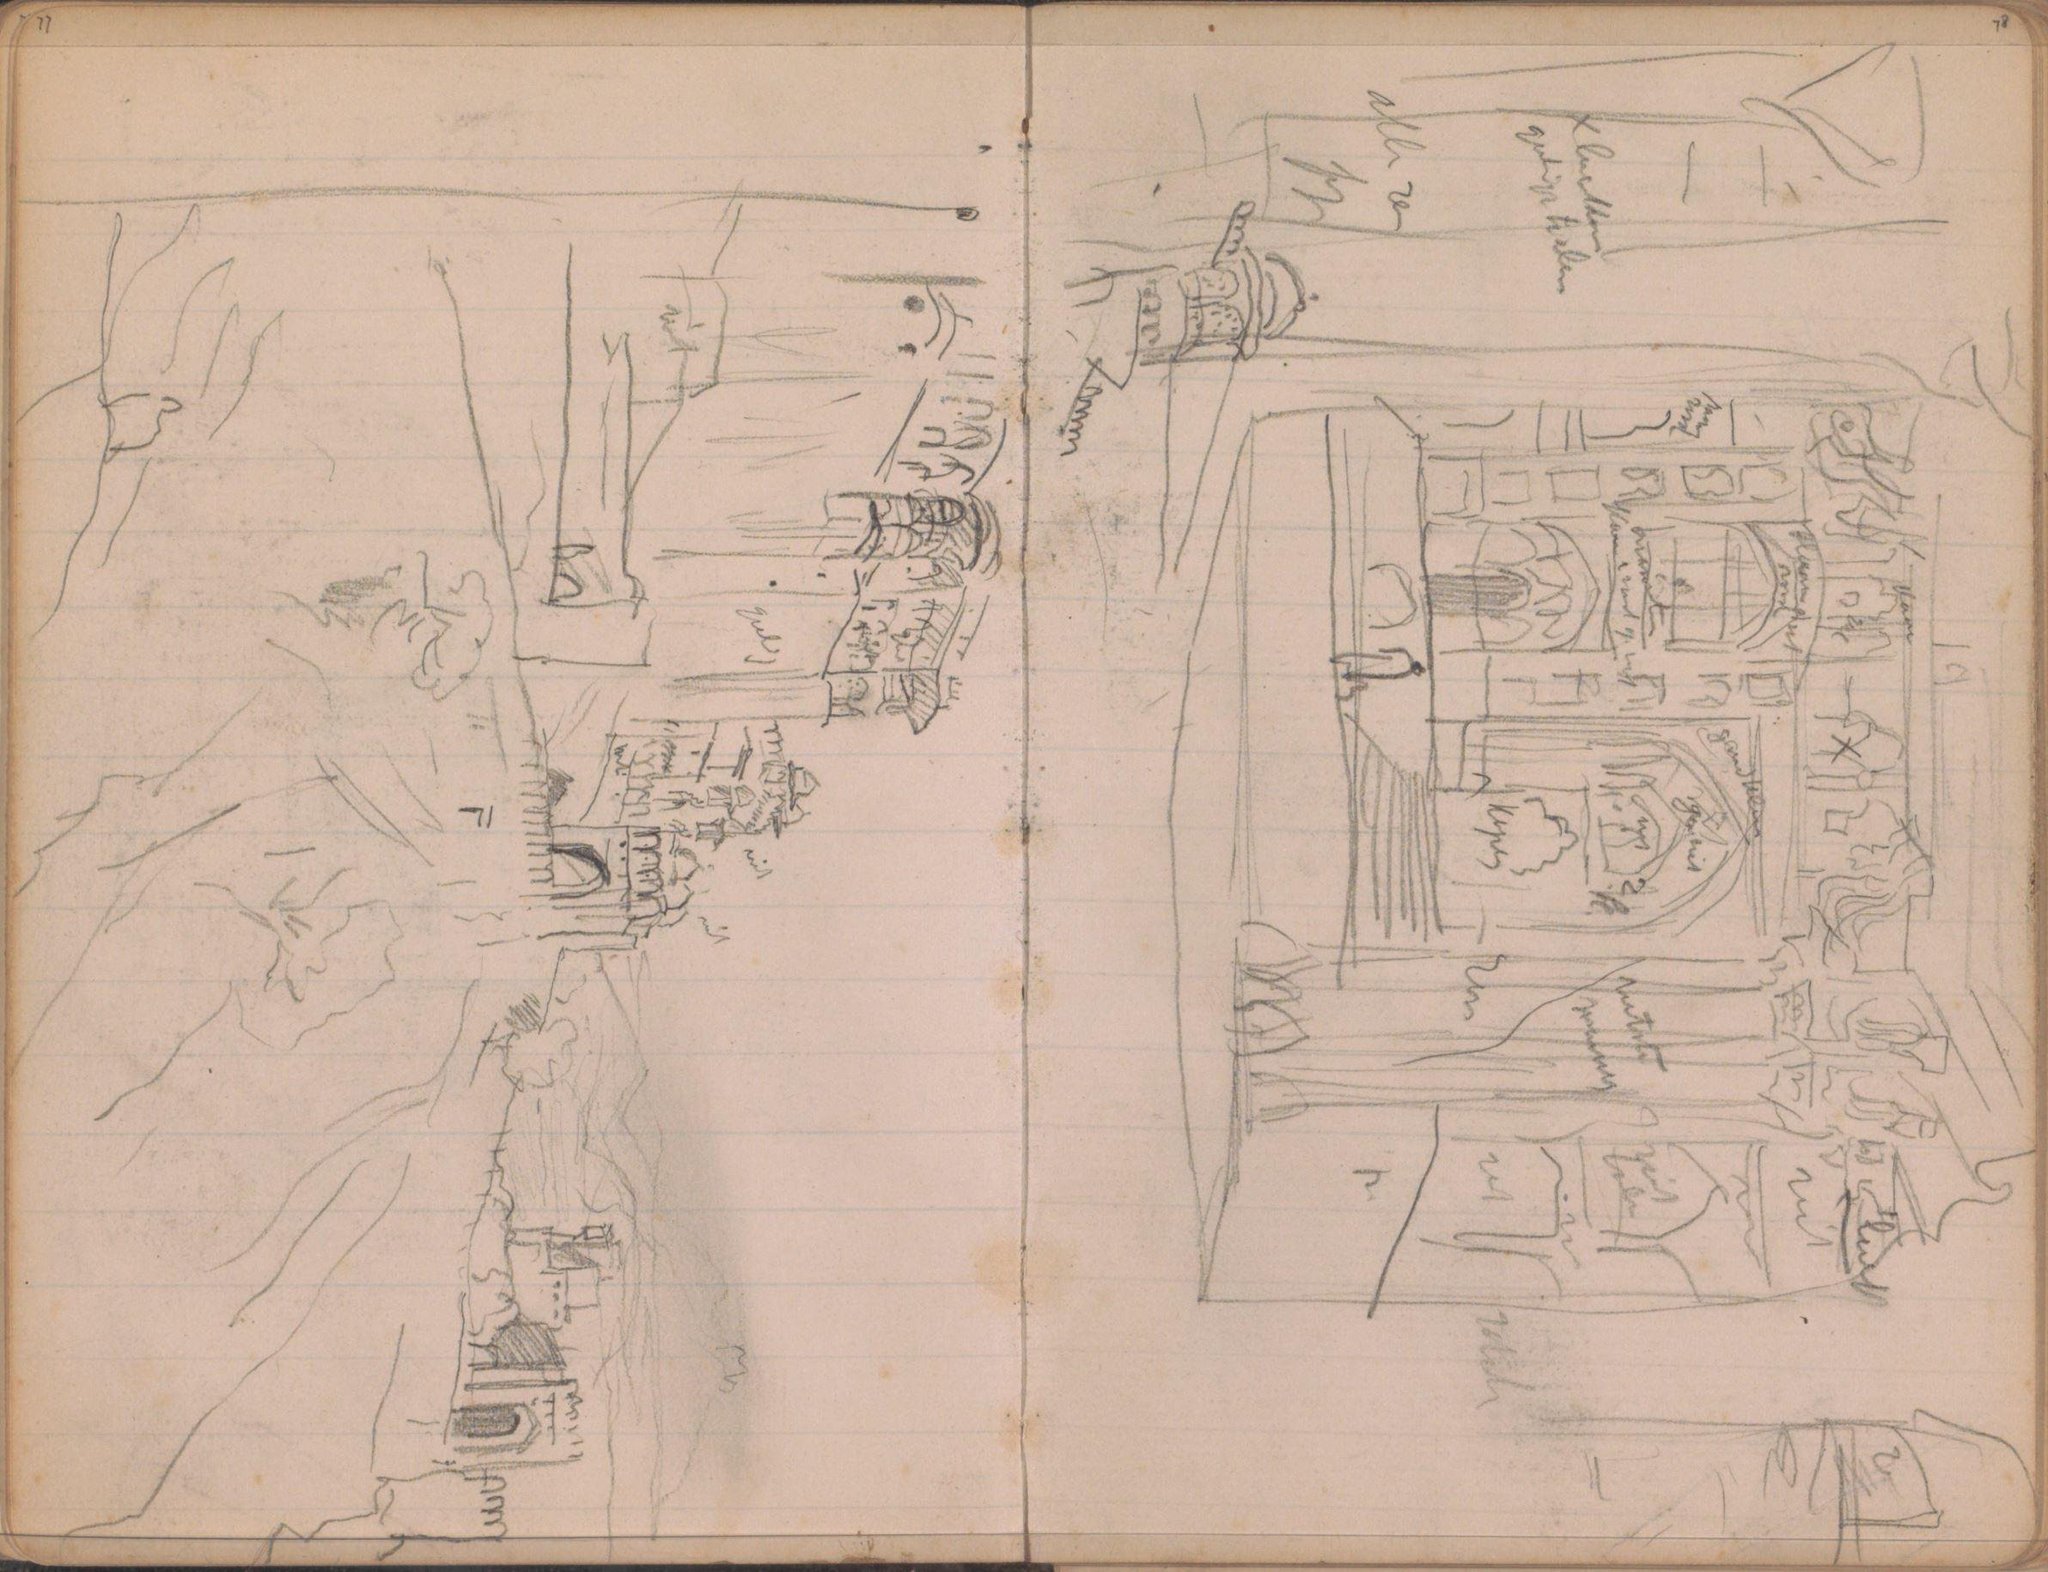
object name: sketchbook leaf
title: Stadgezicht en een figuur op een binnenplaats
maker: marius bauer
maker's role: draughtsman, print maker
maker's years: 1867-1932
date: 1897-1898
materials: pencil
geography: india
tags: city-view, and landscape with man-made constructions, courtyard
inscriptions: kleurnotitie, handgeschreven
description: Pagina 77 en 78 uit een schetsboek met 84 bladen.